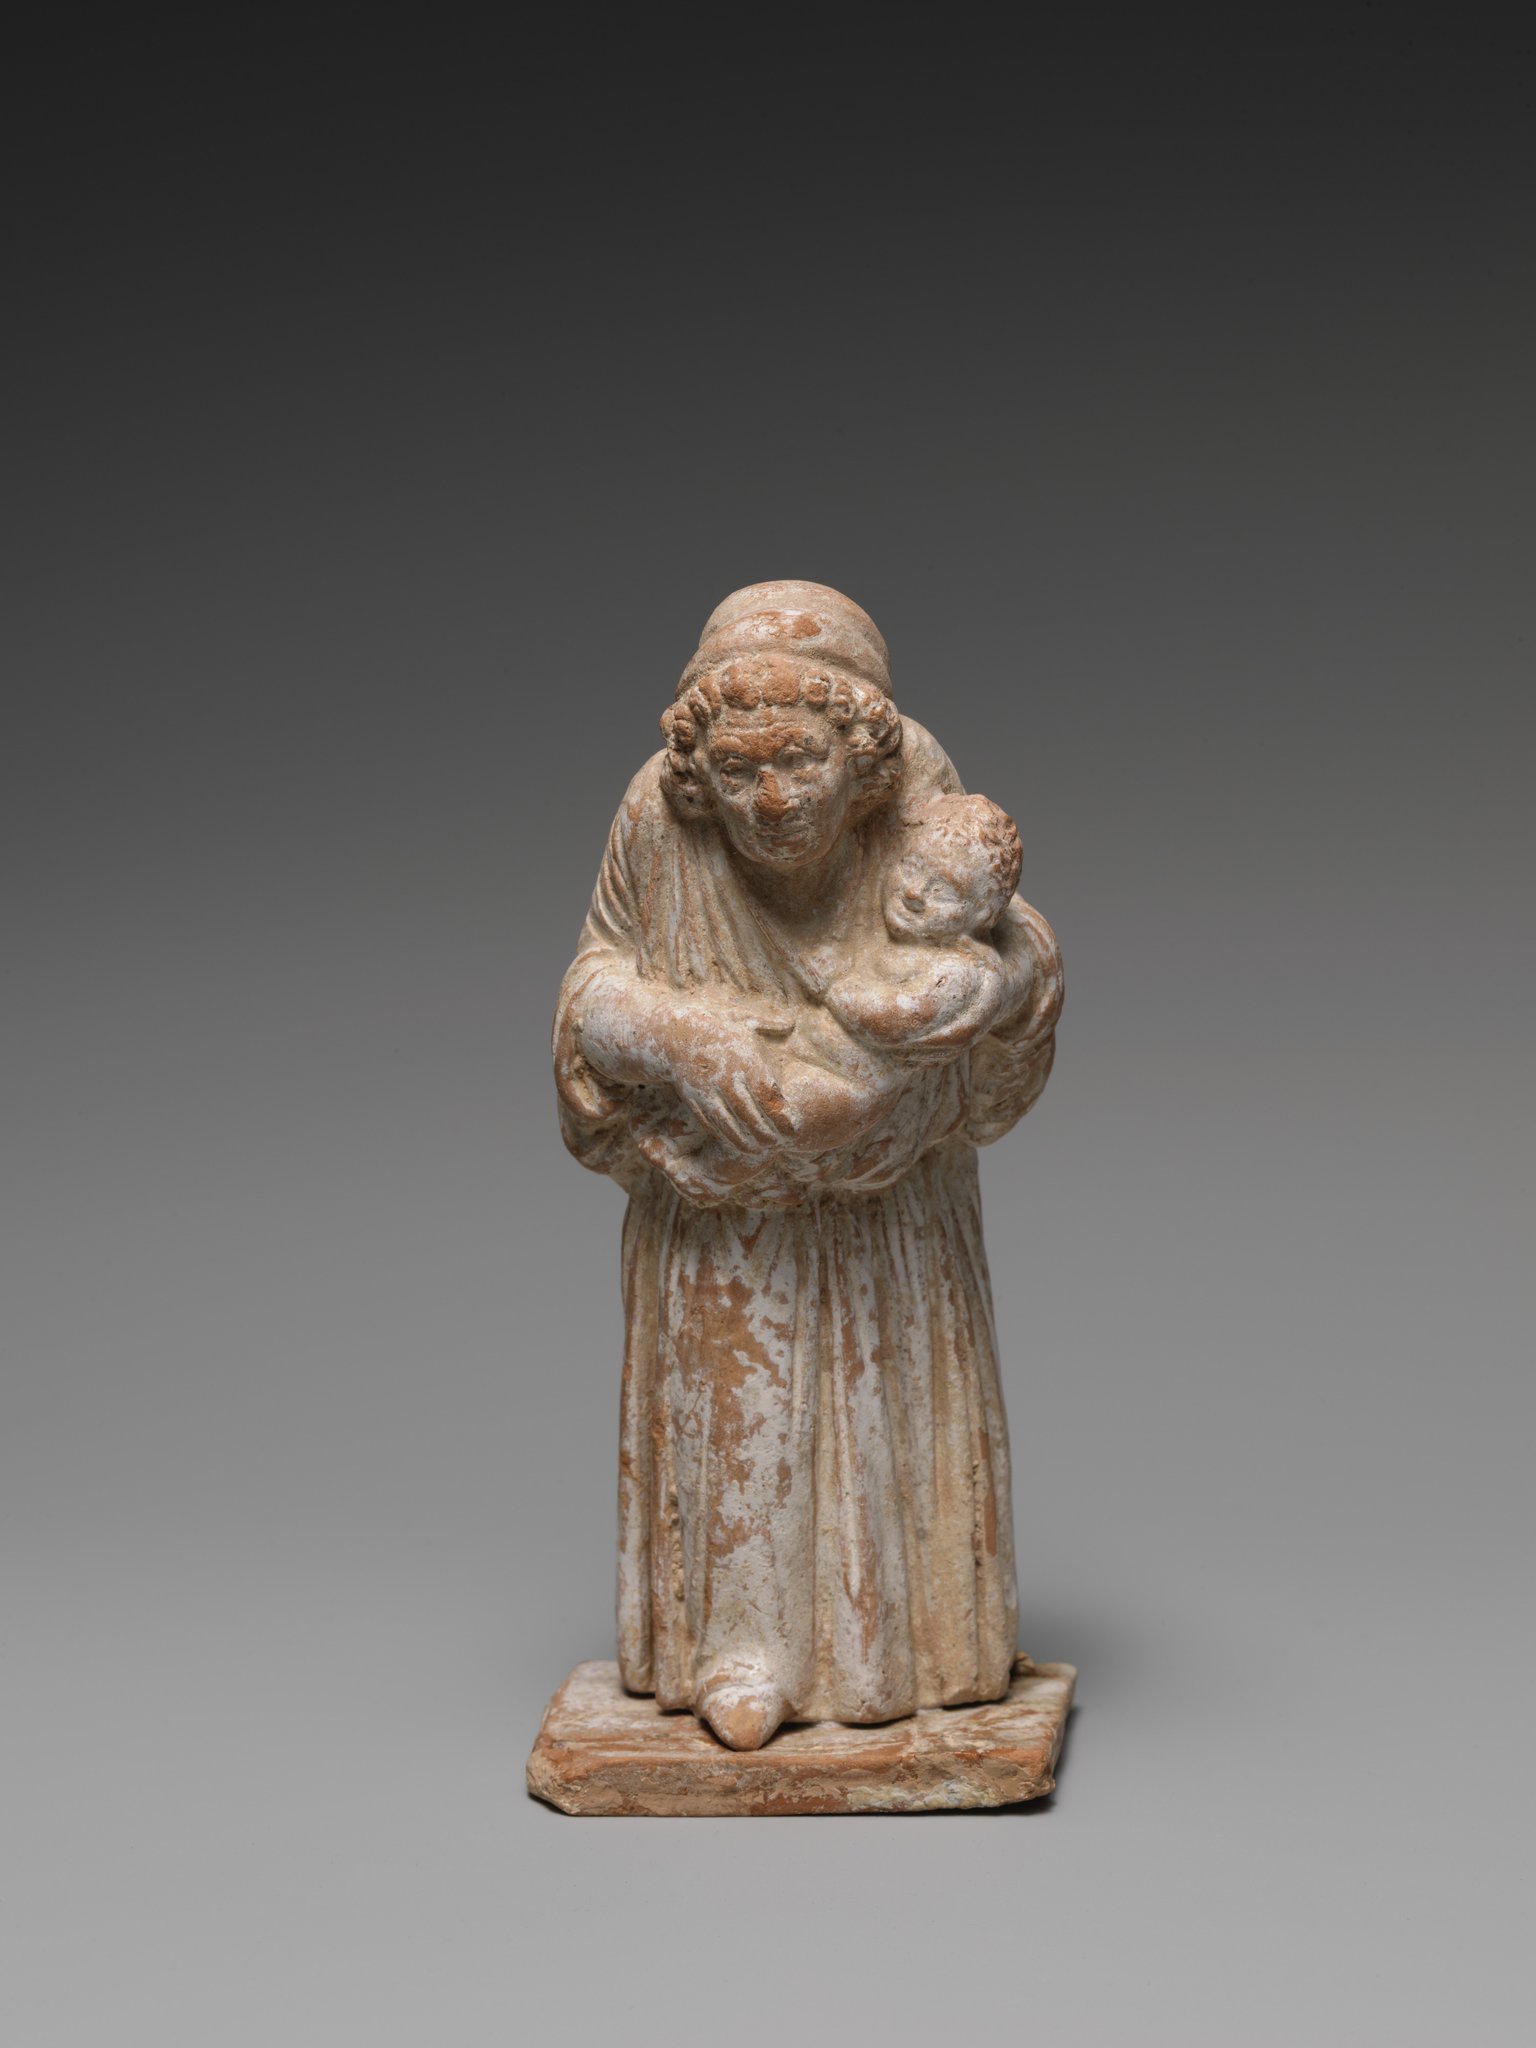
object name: statuette of an old nurse holding child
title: Terracotta statuette of an old nurse holding a child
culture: greek, attic or boeotian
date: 325-301 BCE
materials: terracotta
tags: children,women